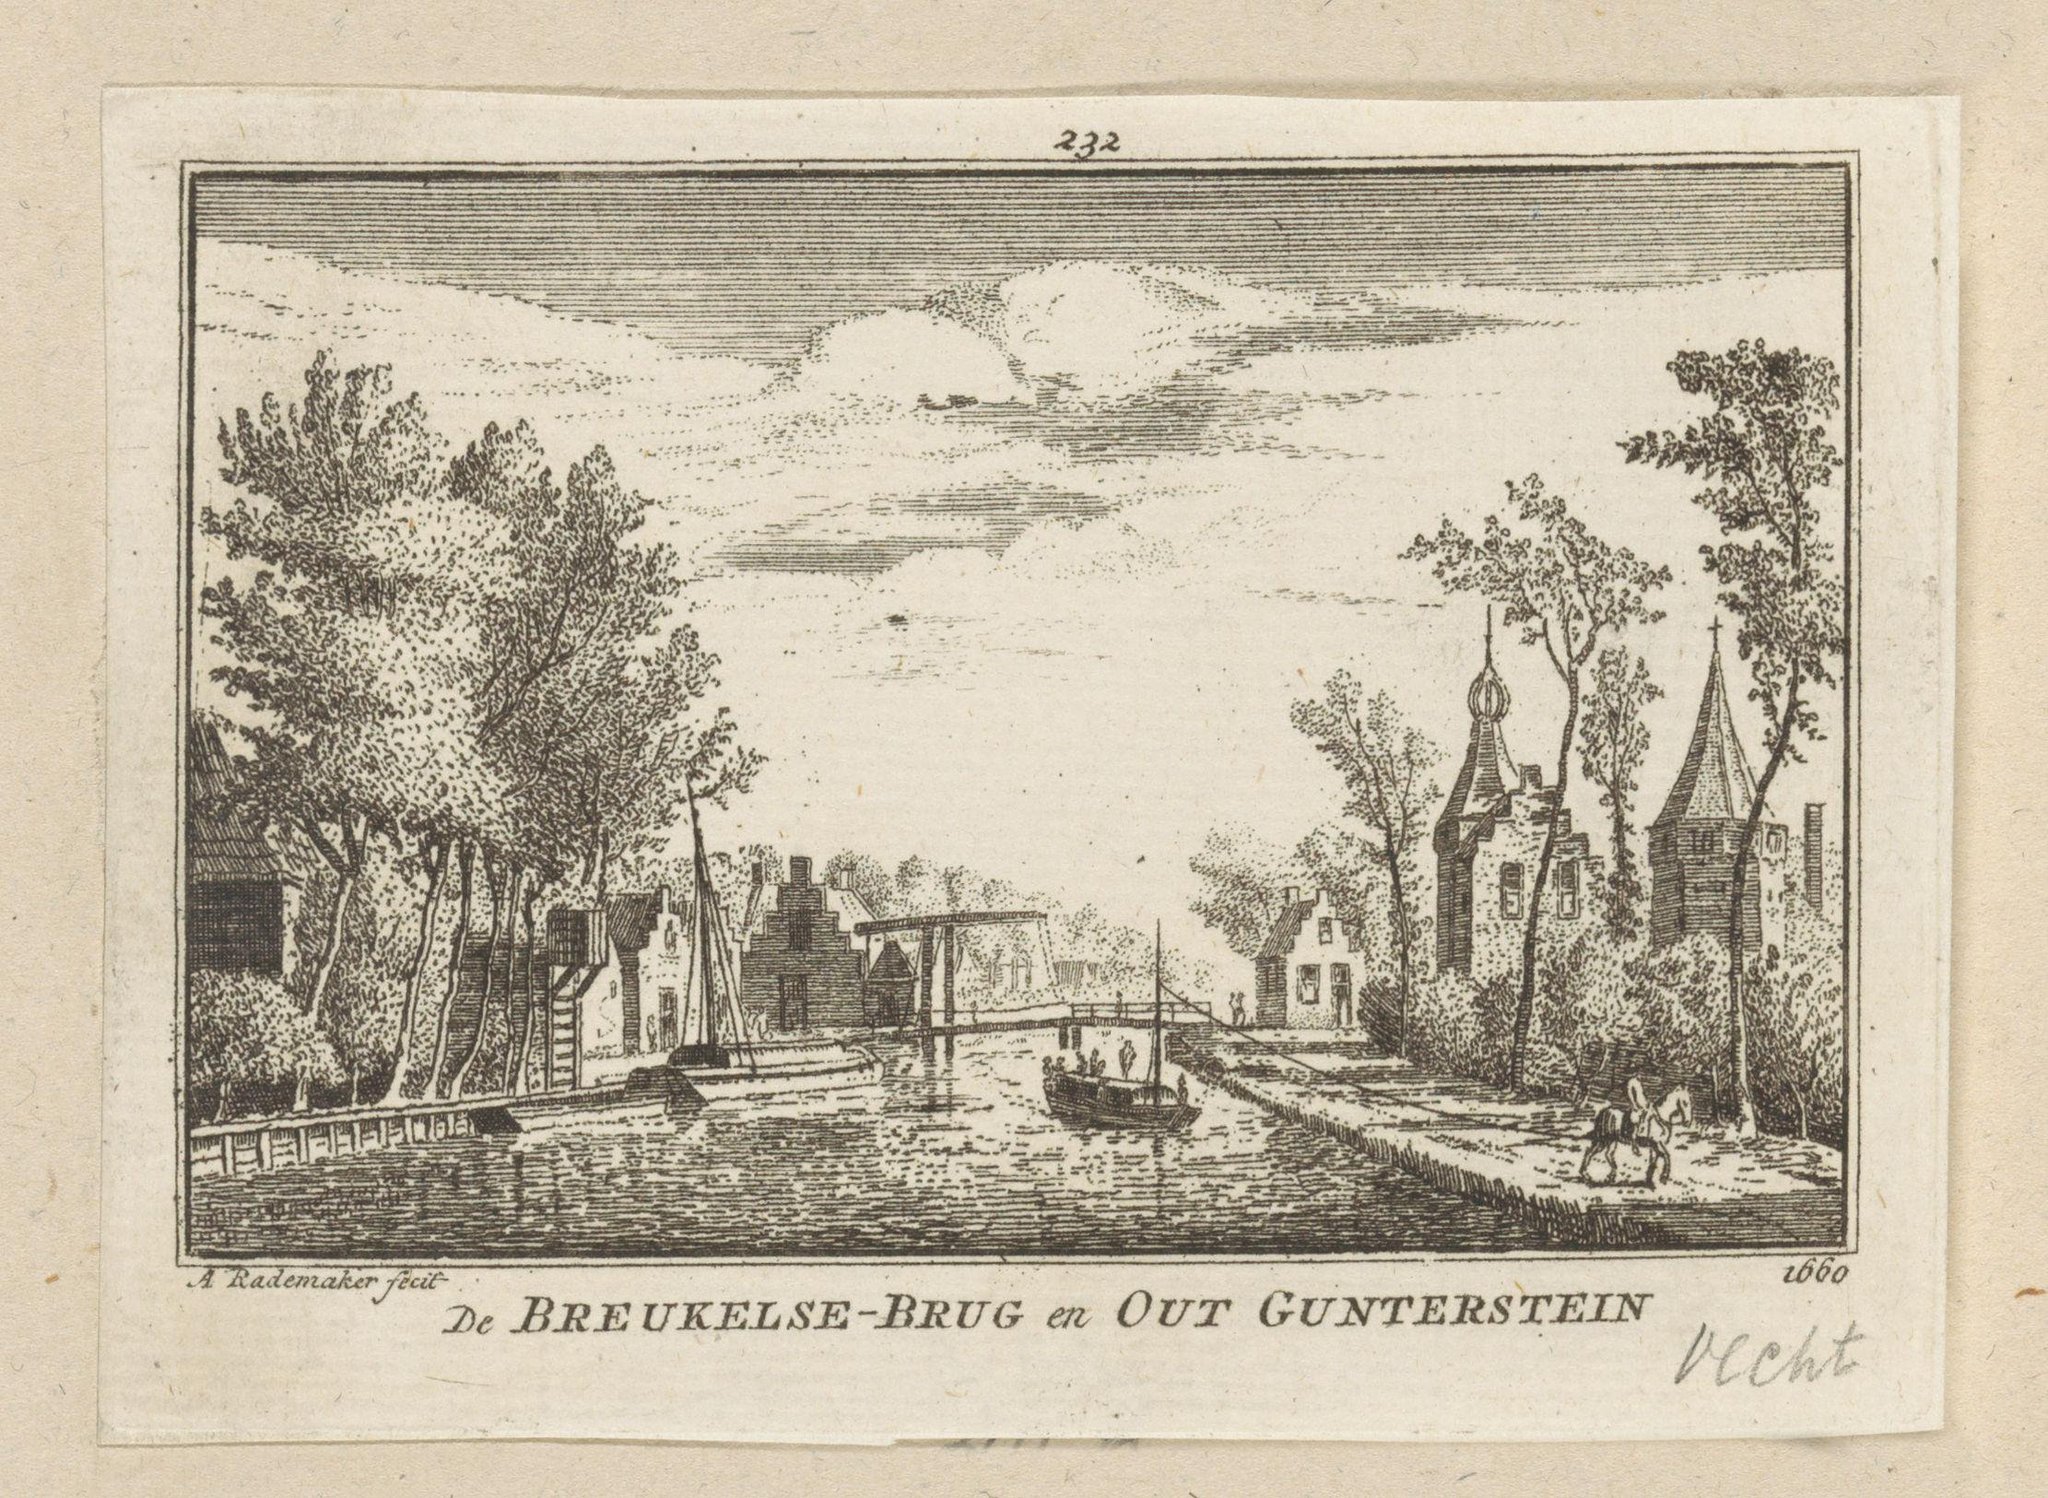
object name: print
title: Gezicht op de Breukelse brug bij Gunterstein, 1660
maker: abraham rademaker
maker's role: draughtsman, print maker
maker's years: 1676-1735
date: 1725-1803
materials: paper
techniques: engraving, etching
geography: amsterdam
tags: prospect of village, silhouette of village, sailing-ship, sailing-boat, castle, vecht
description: Prent ook gebruikt in: Rademaker, Abraham. Kabinet van Nederlandsche outheden en gezichten: vervat in 300 konstplaaten (…). 2 delen. Amsterdam: Willem Barents, 1725, dl. 2, ill. 232. Na 1725 is deze prent nog in verschillende heruitgaven verschenen, uitgegeven in 1727-1733, 1770-1771 en 1792-1803. Uit welke uitgave het huidige exemplaar precies komt is niet na te gaan.